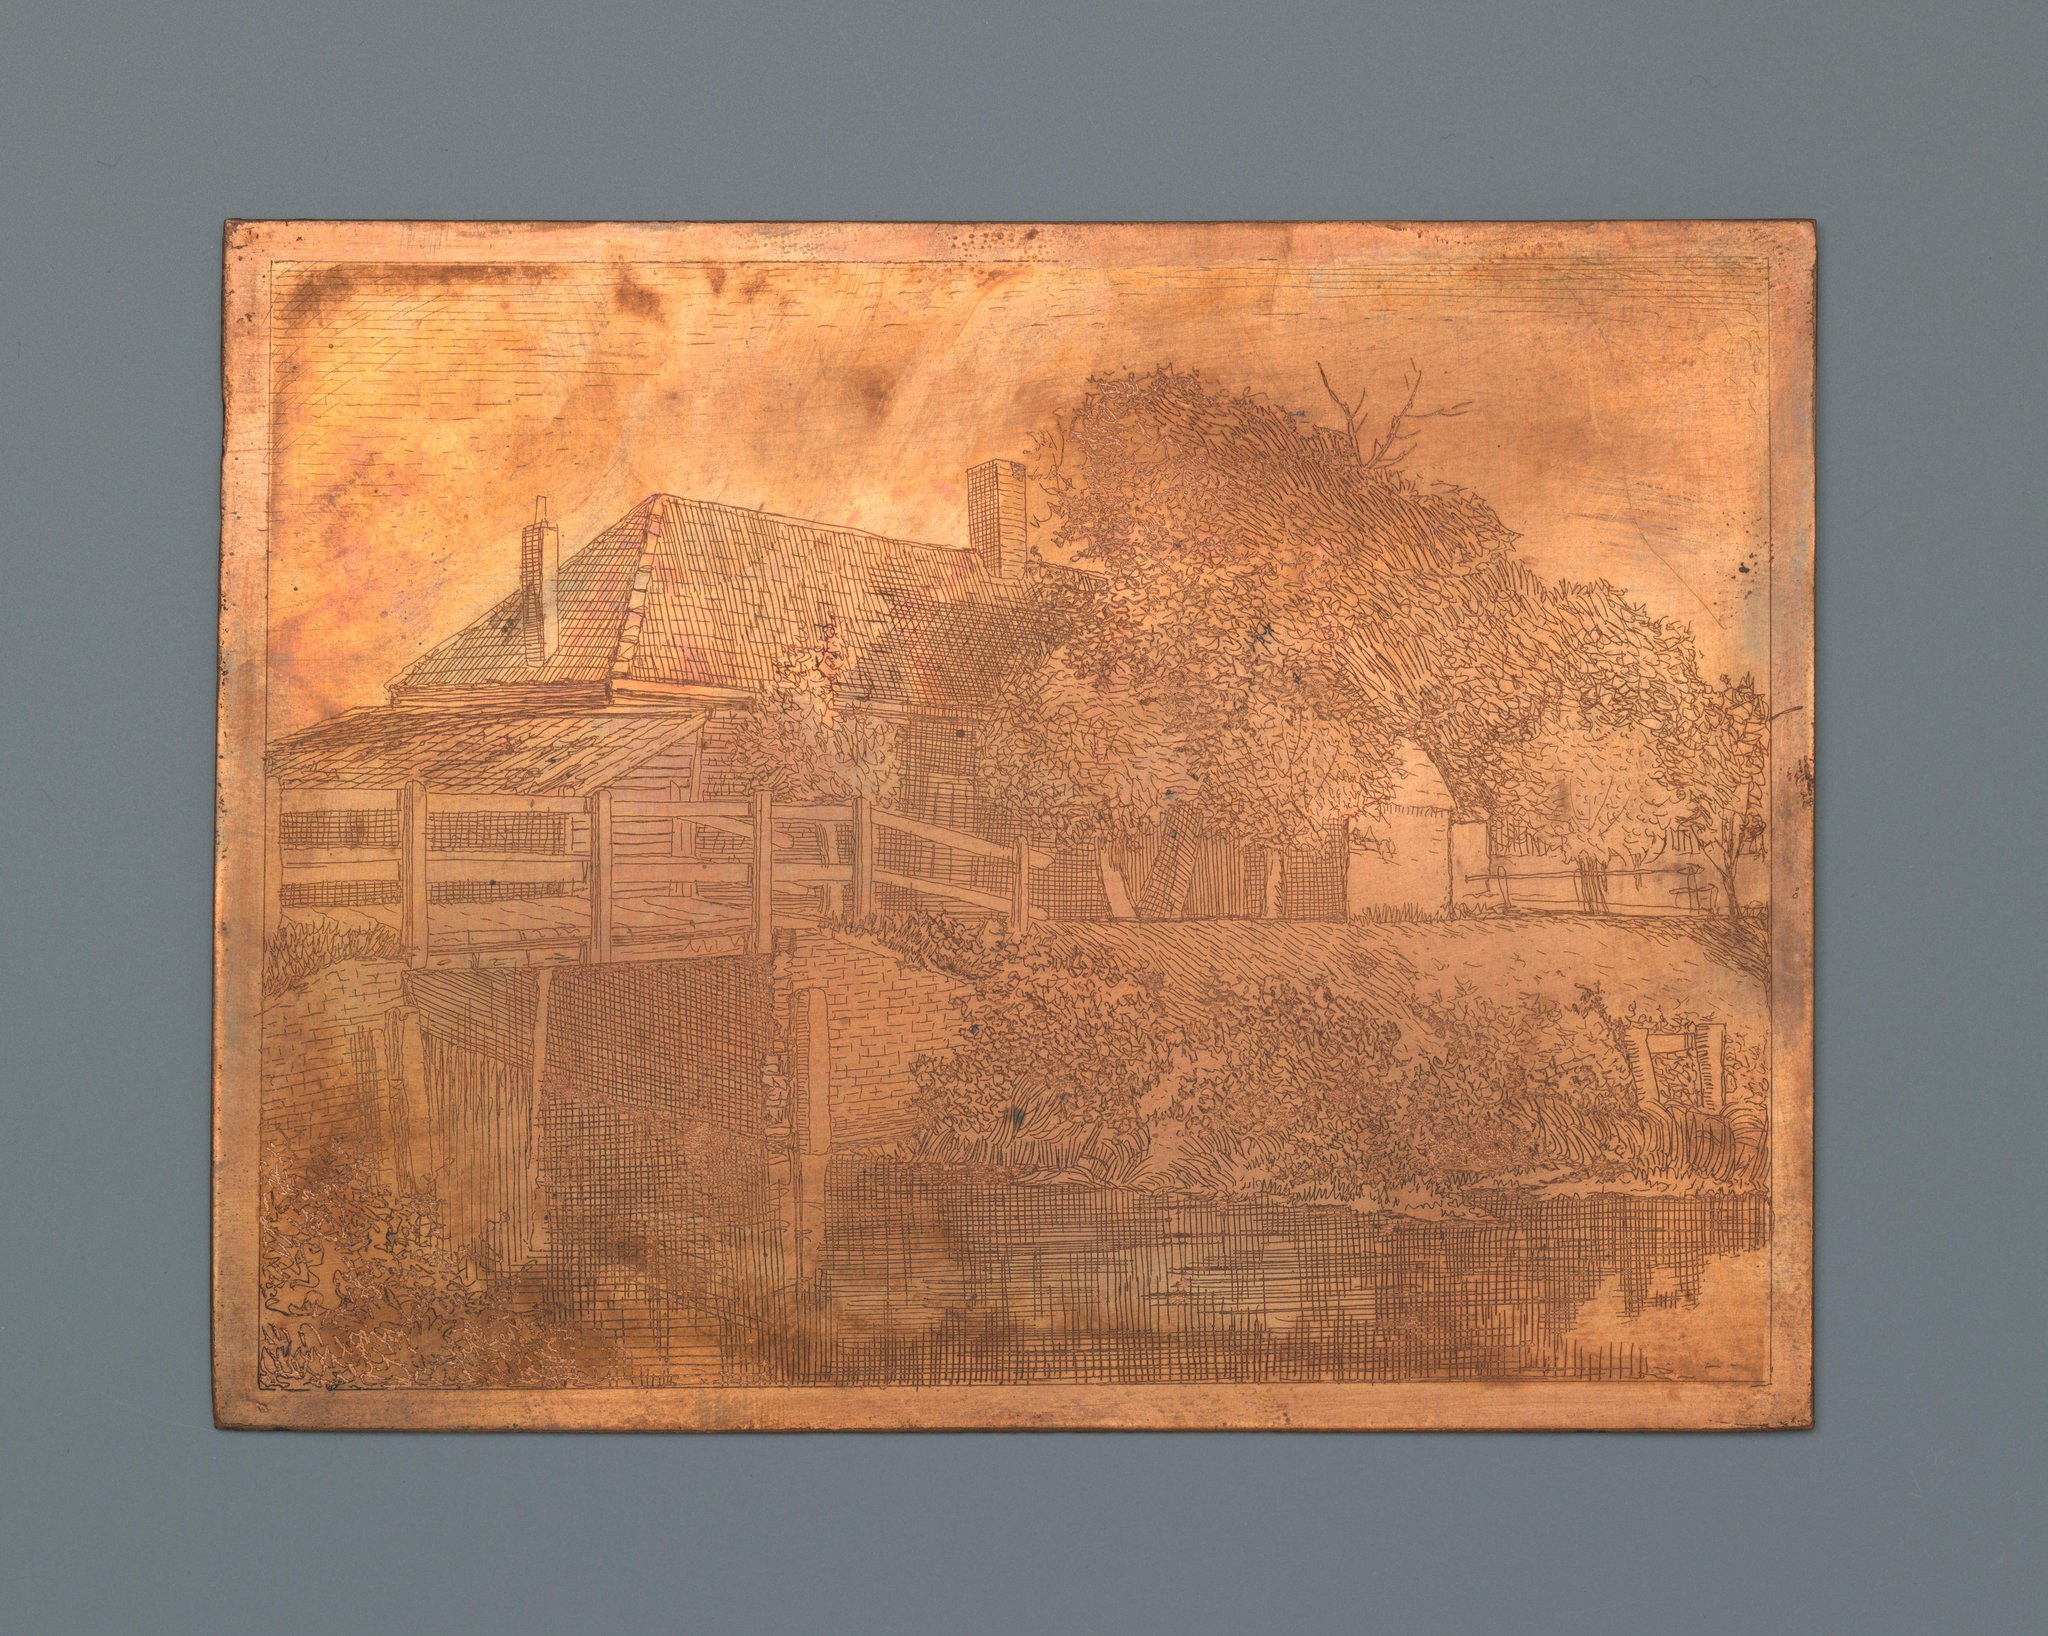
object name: copper plate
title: Boerderij met sloot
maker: johannes josephus aarts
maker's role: draughtsman, print maker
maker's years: 1871-1934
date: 1905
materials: copper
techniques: etching